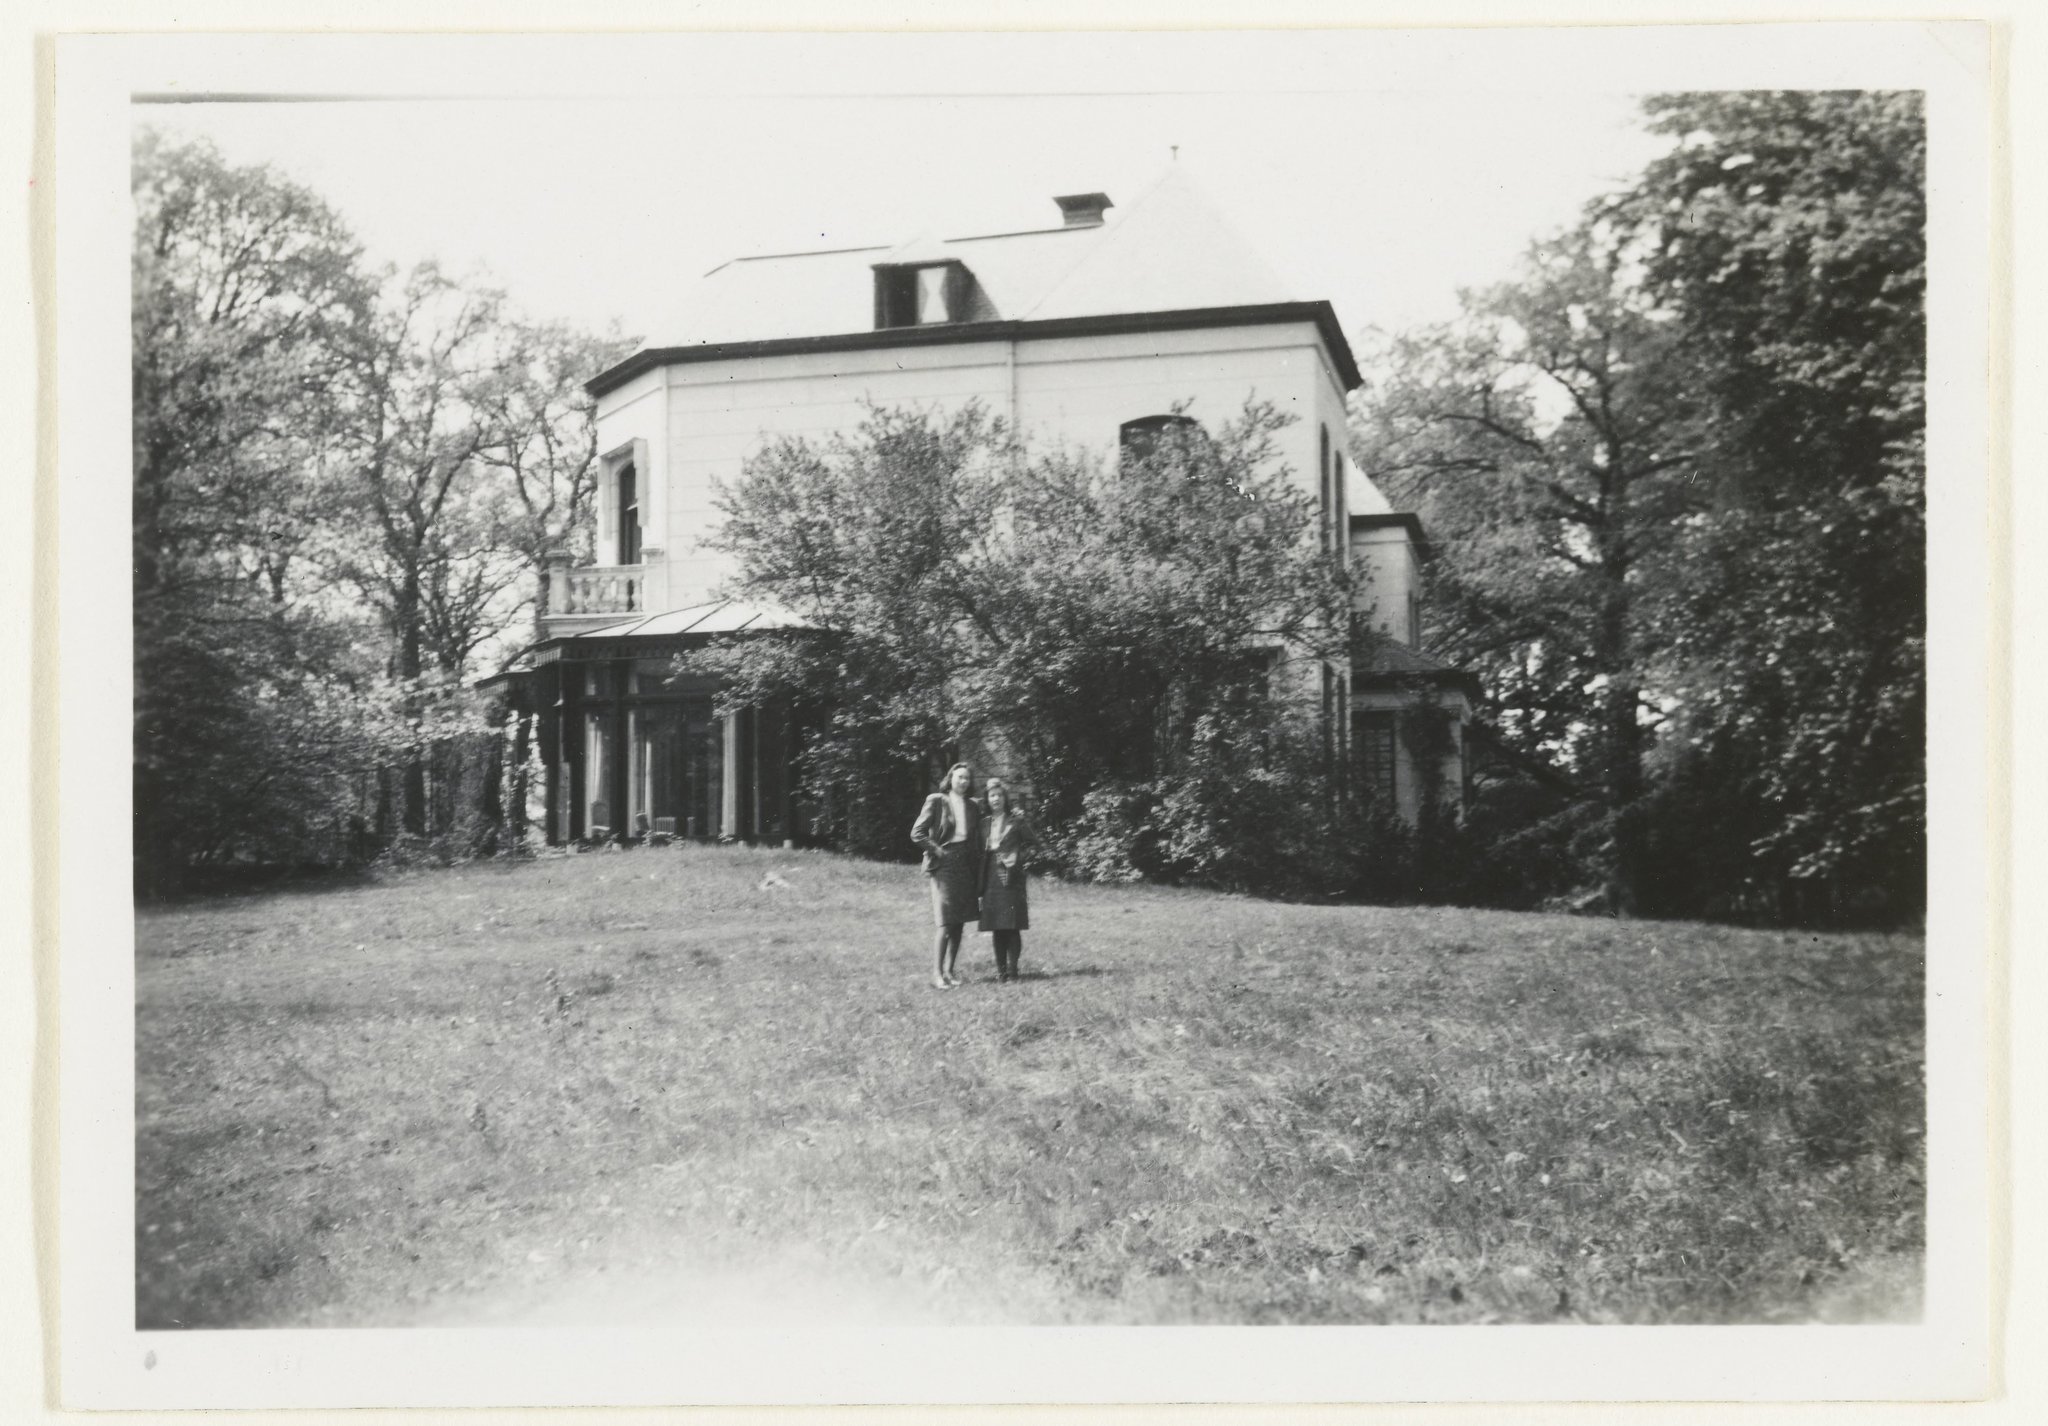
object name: photograph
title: Twee jonge vrouwen bij een villa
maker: Anonymous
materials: photographic support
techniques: gelatin silver print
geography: netherlands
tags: occupier and civilians, occupation ~ war, netherlands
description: Op een grasveld staan twee jonge vrouwen. Achter hen een een grote villa. Daarom heen bomen.